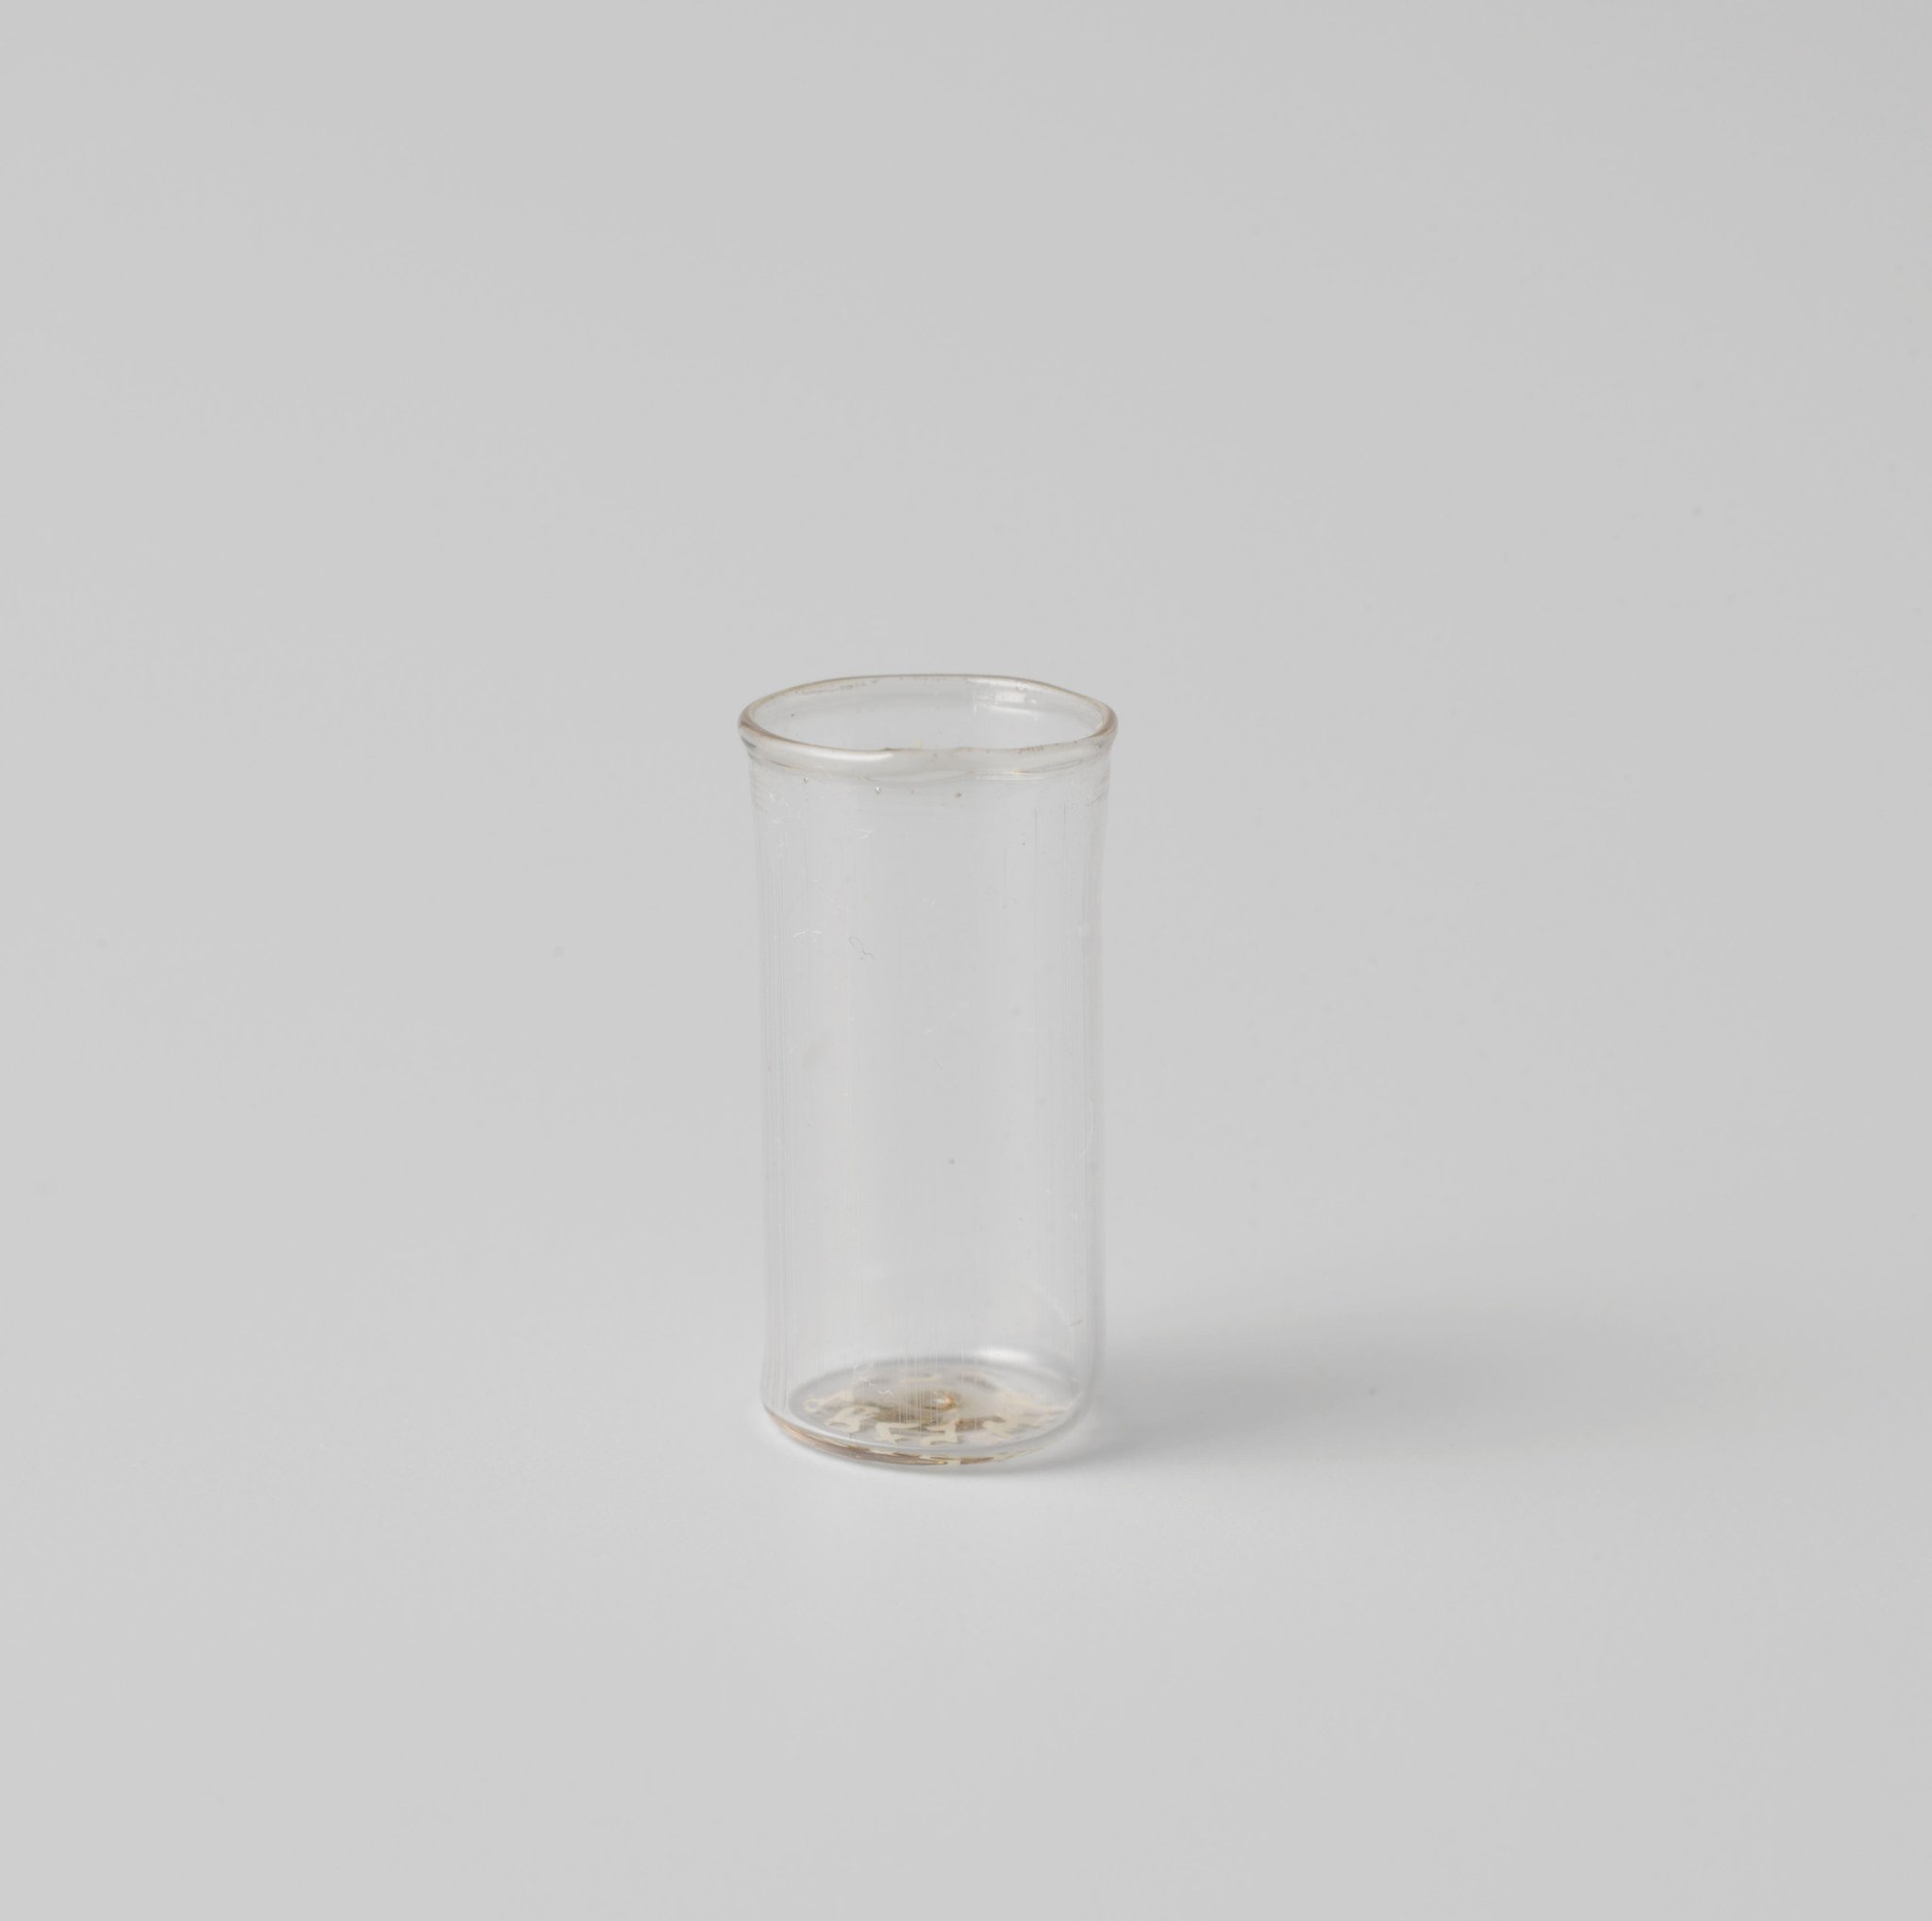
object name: cup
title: Beker, cilindrisch, met vlakke bodem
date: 1675-1699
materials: glass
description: Een cilindrische beker van helder kleurloos glas met vlakke bodem.